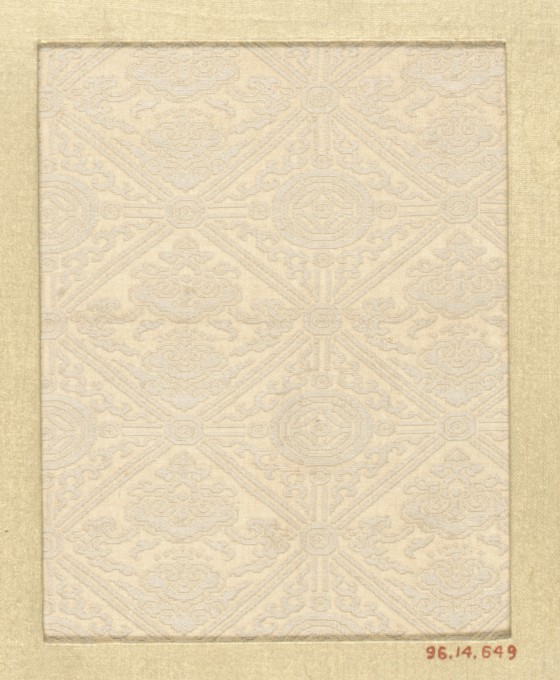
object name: piece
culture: japanese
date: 1701-1900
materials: silk